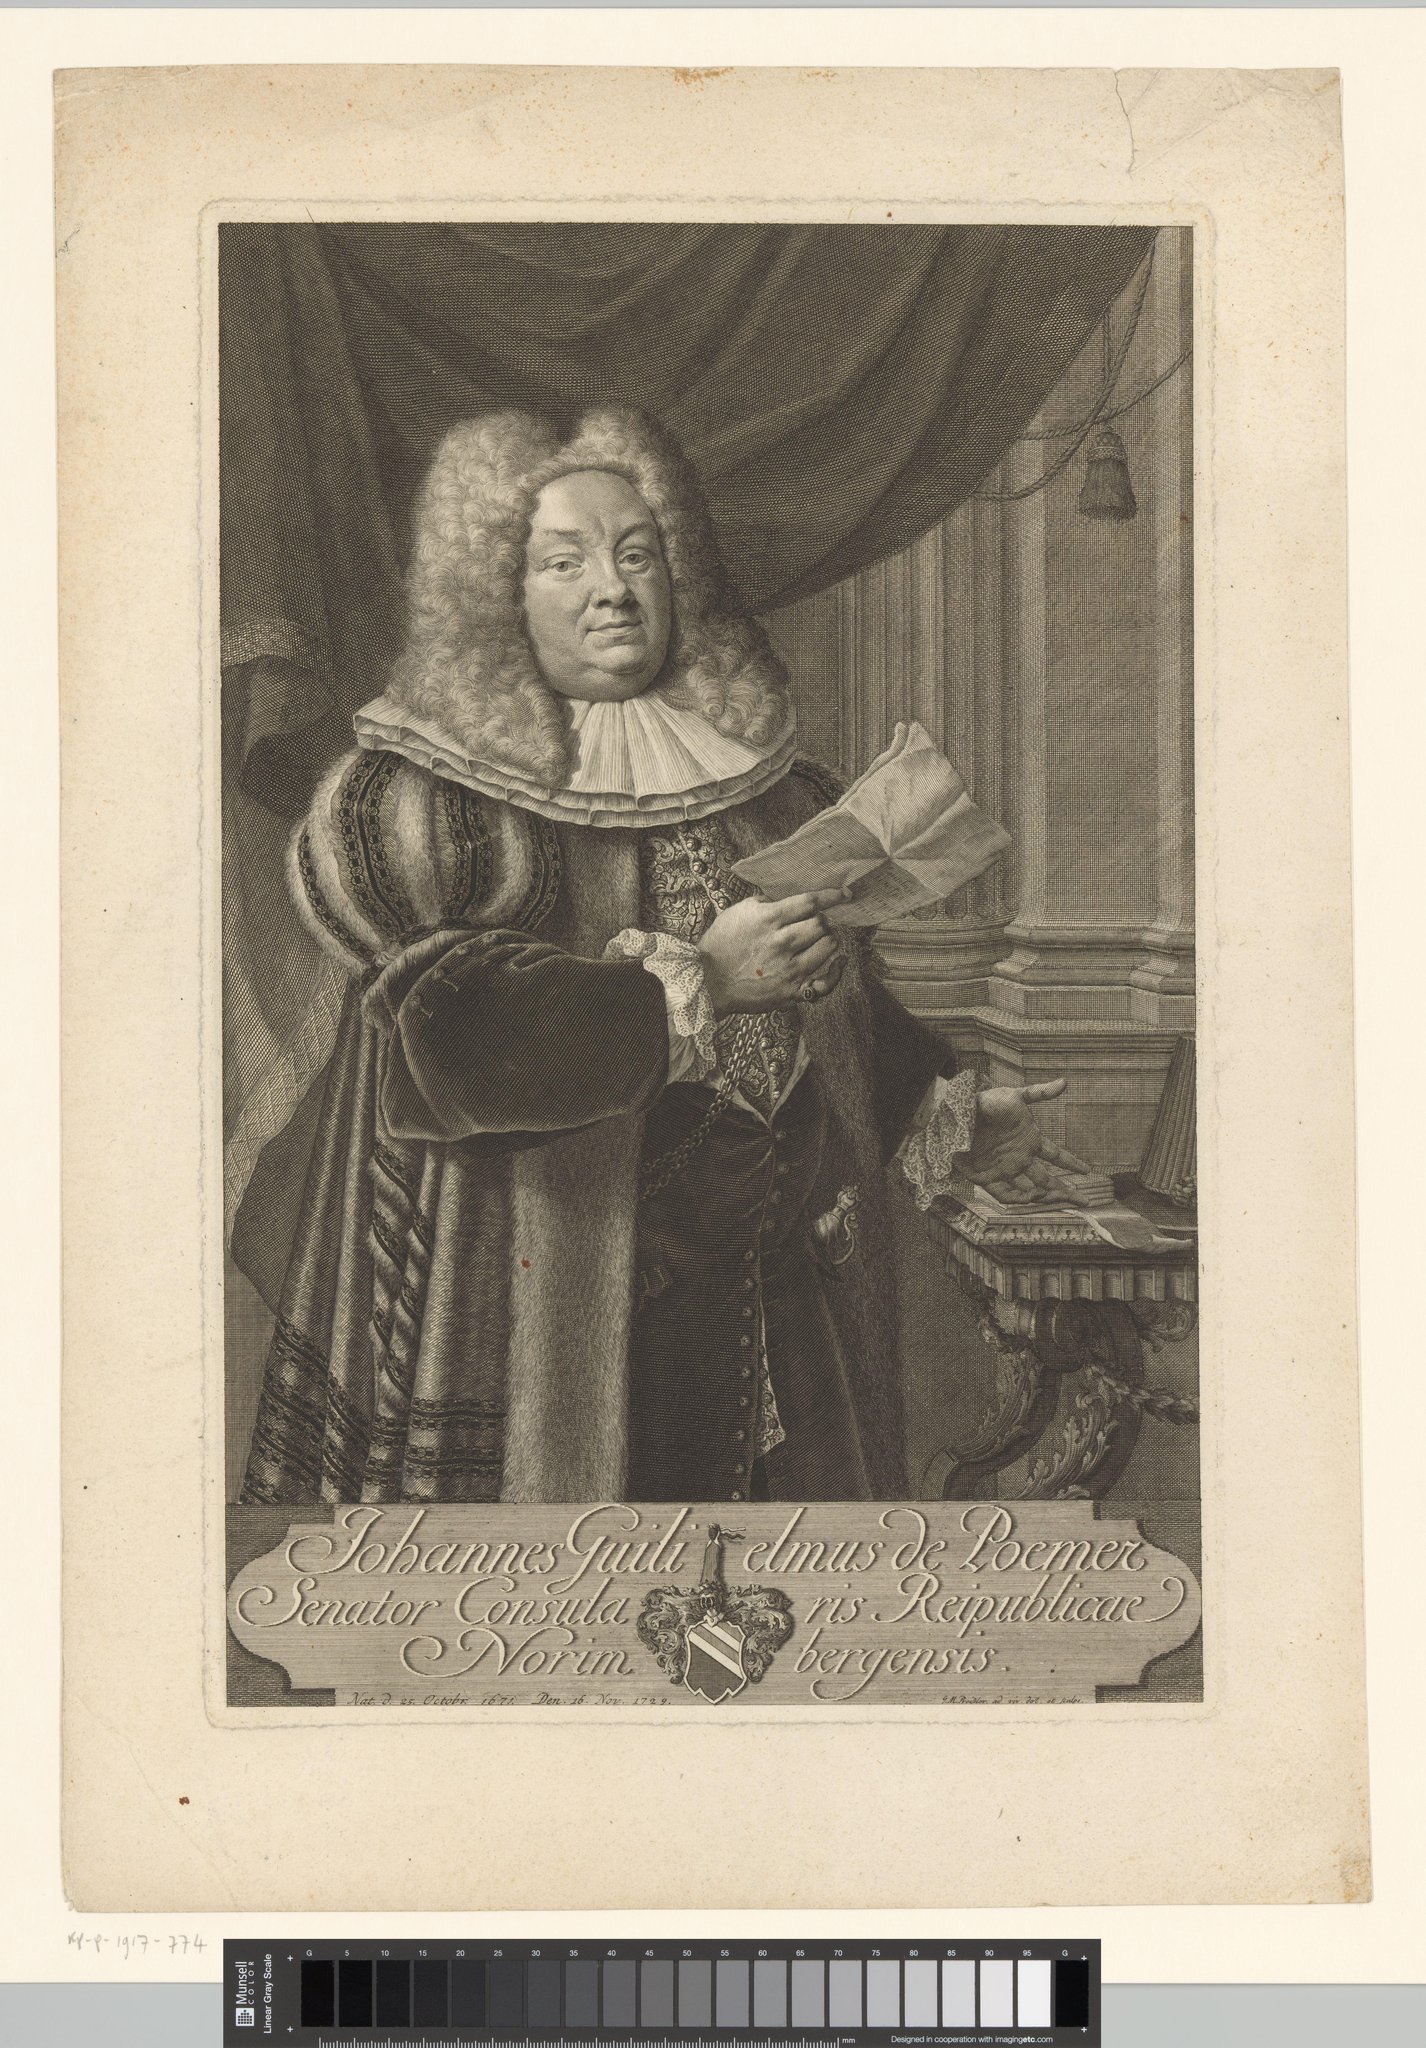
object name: print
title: Portret van Johann Wilhelm Poemer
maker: georg martin preissler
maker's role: print maker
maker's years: 1700-1754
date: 1729-1754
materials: paper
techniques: engraving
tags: other non-personal regalia, e.g. mayor chain, historical persons, hacking and thrusting weapons: sword, ring, letter, envelope, armorial bearing, heraldry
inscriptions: collector's mark: Lugt 2228